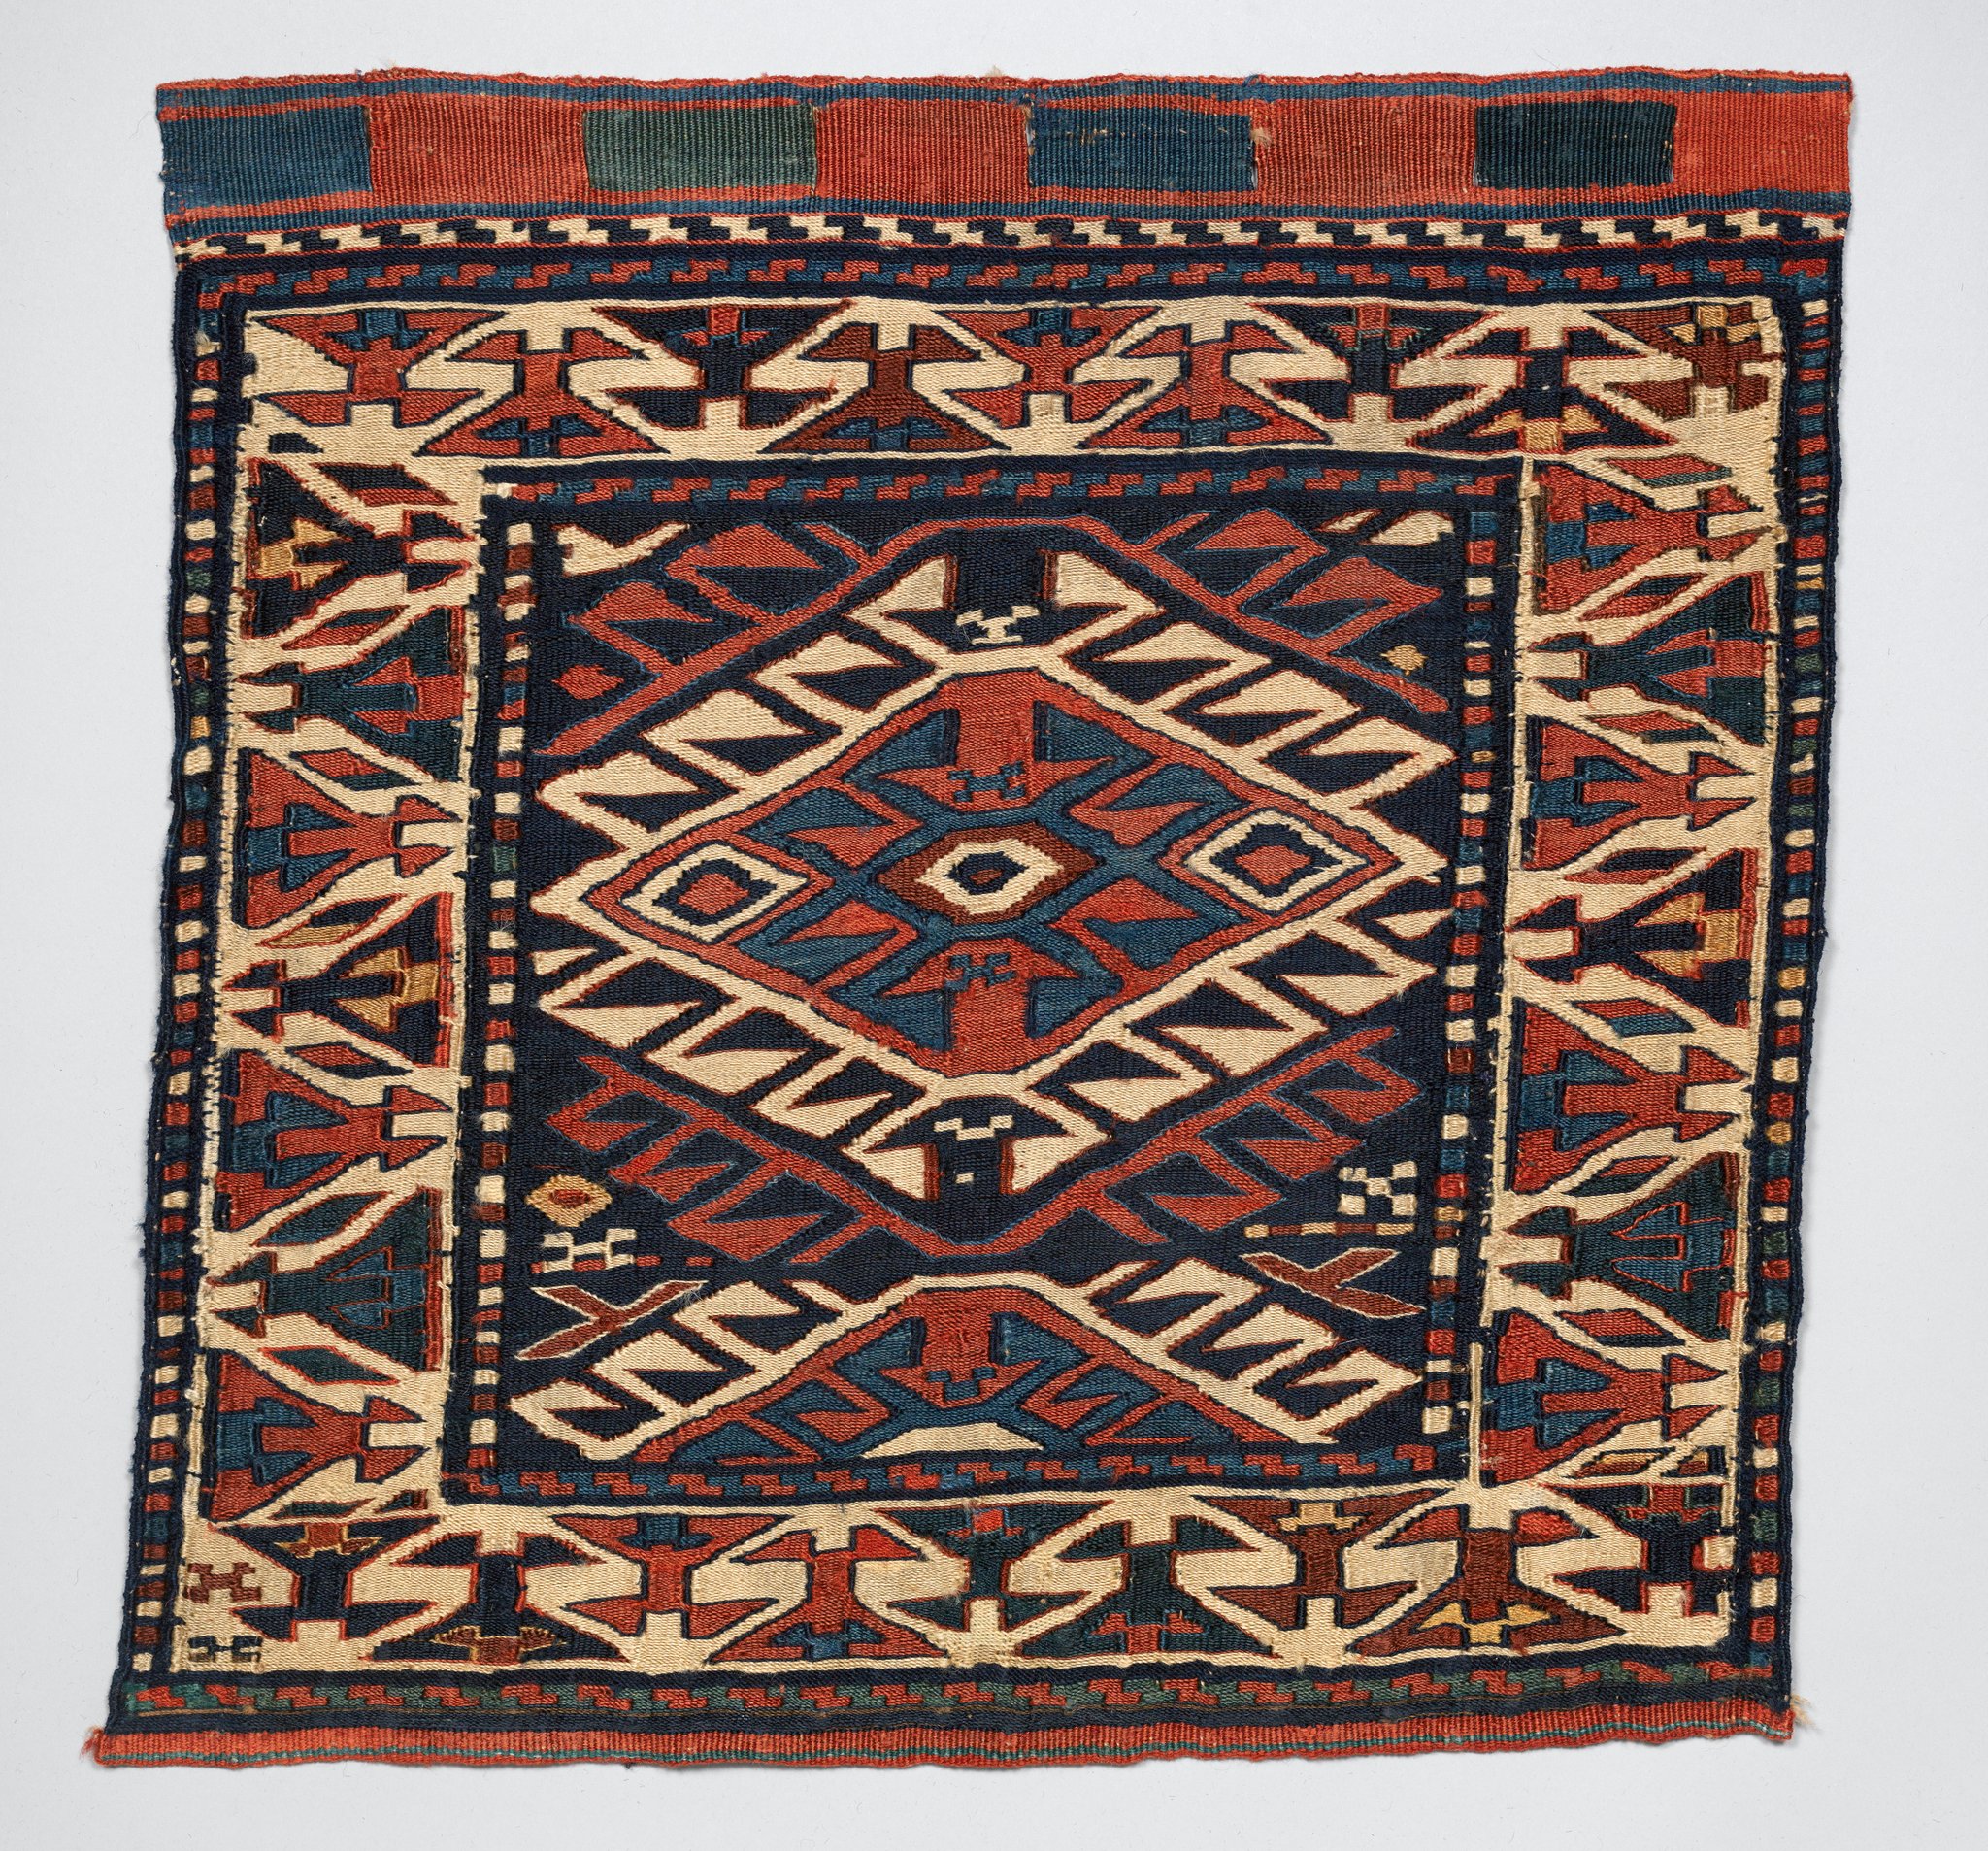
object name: saddle bag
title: Face of Half a Double Saddle Bag (Khorjin)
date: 1834-1866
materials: wool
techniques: tapestry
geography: iran